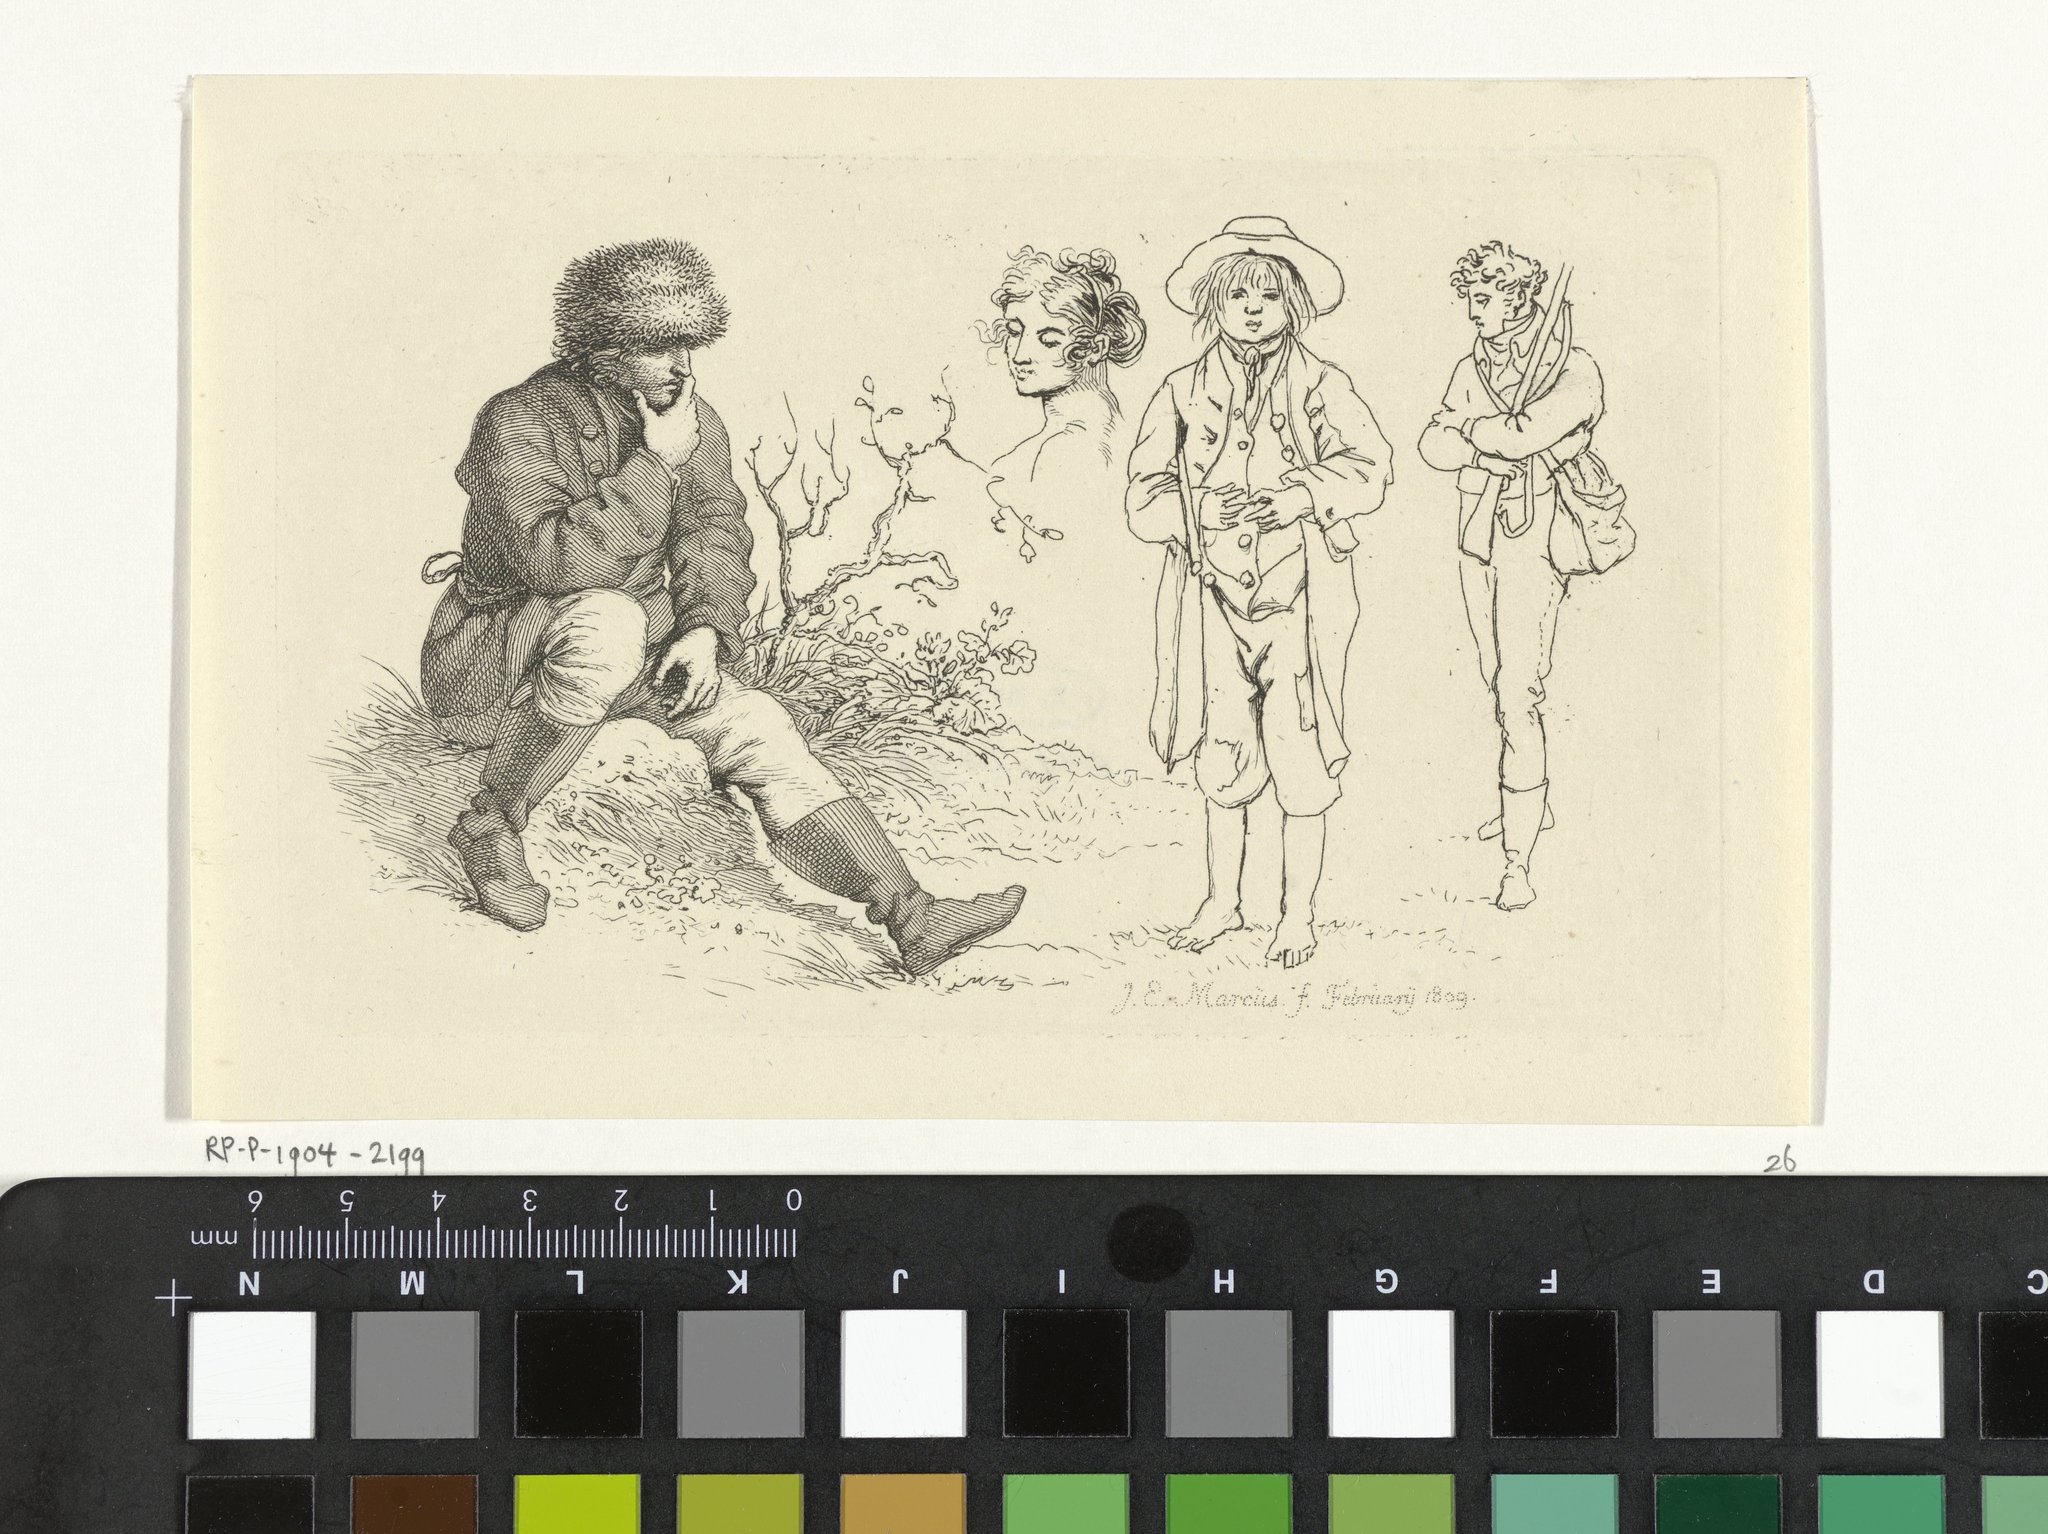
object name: print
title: Studie-prentwerk / Etudes gravées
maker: jacob ernst marcus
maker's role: draughtsman, print maker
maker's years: 1774-1826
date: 1802-1809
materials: paper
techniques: etching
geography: amsterdam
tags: hand touching the beard, sitting on the ground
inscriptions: collector's mark: Lugt 2228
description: Serie voor het eerst uitgegeven door Jacob Ernst Marcus onder de titel Studiebeelden en Fragmenten. Amsterdam: ca.1816. Later heruitgegeven als: Studie-prentwerk/ Etudes gravées.